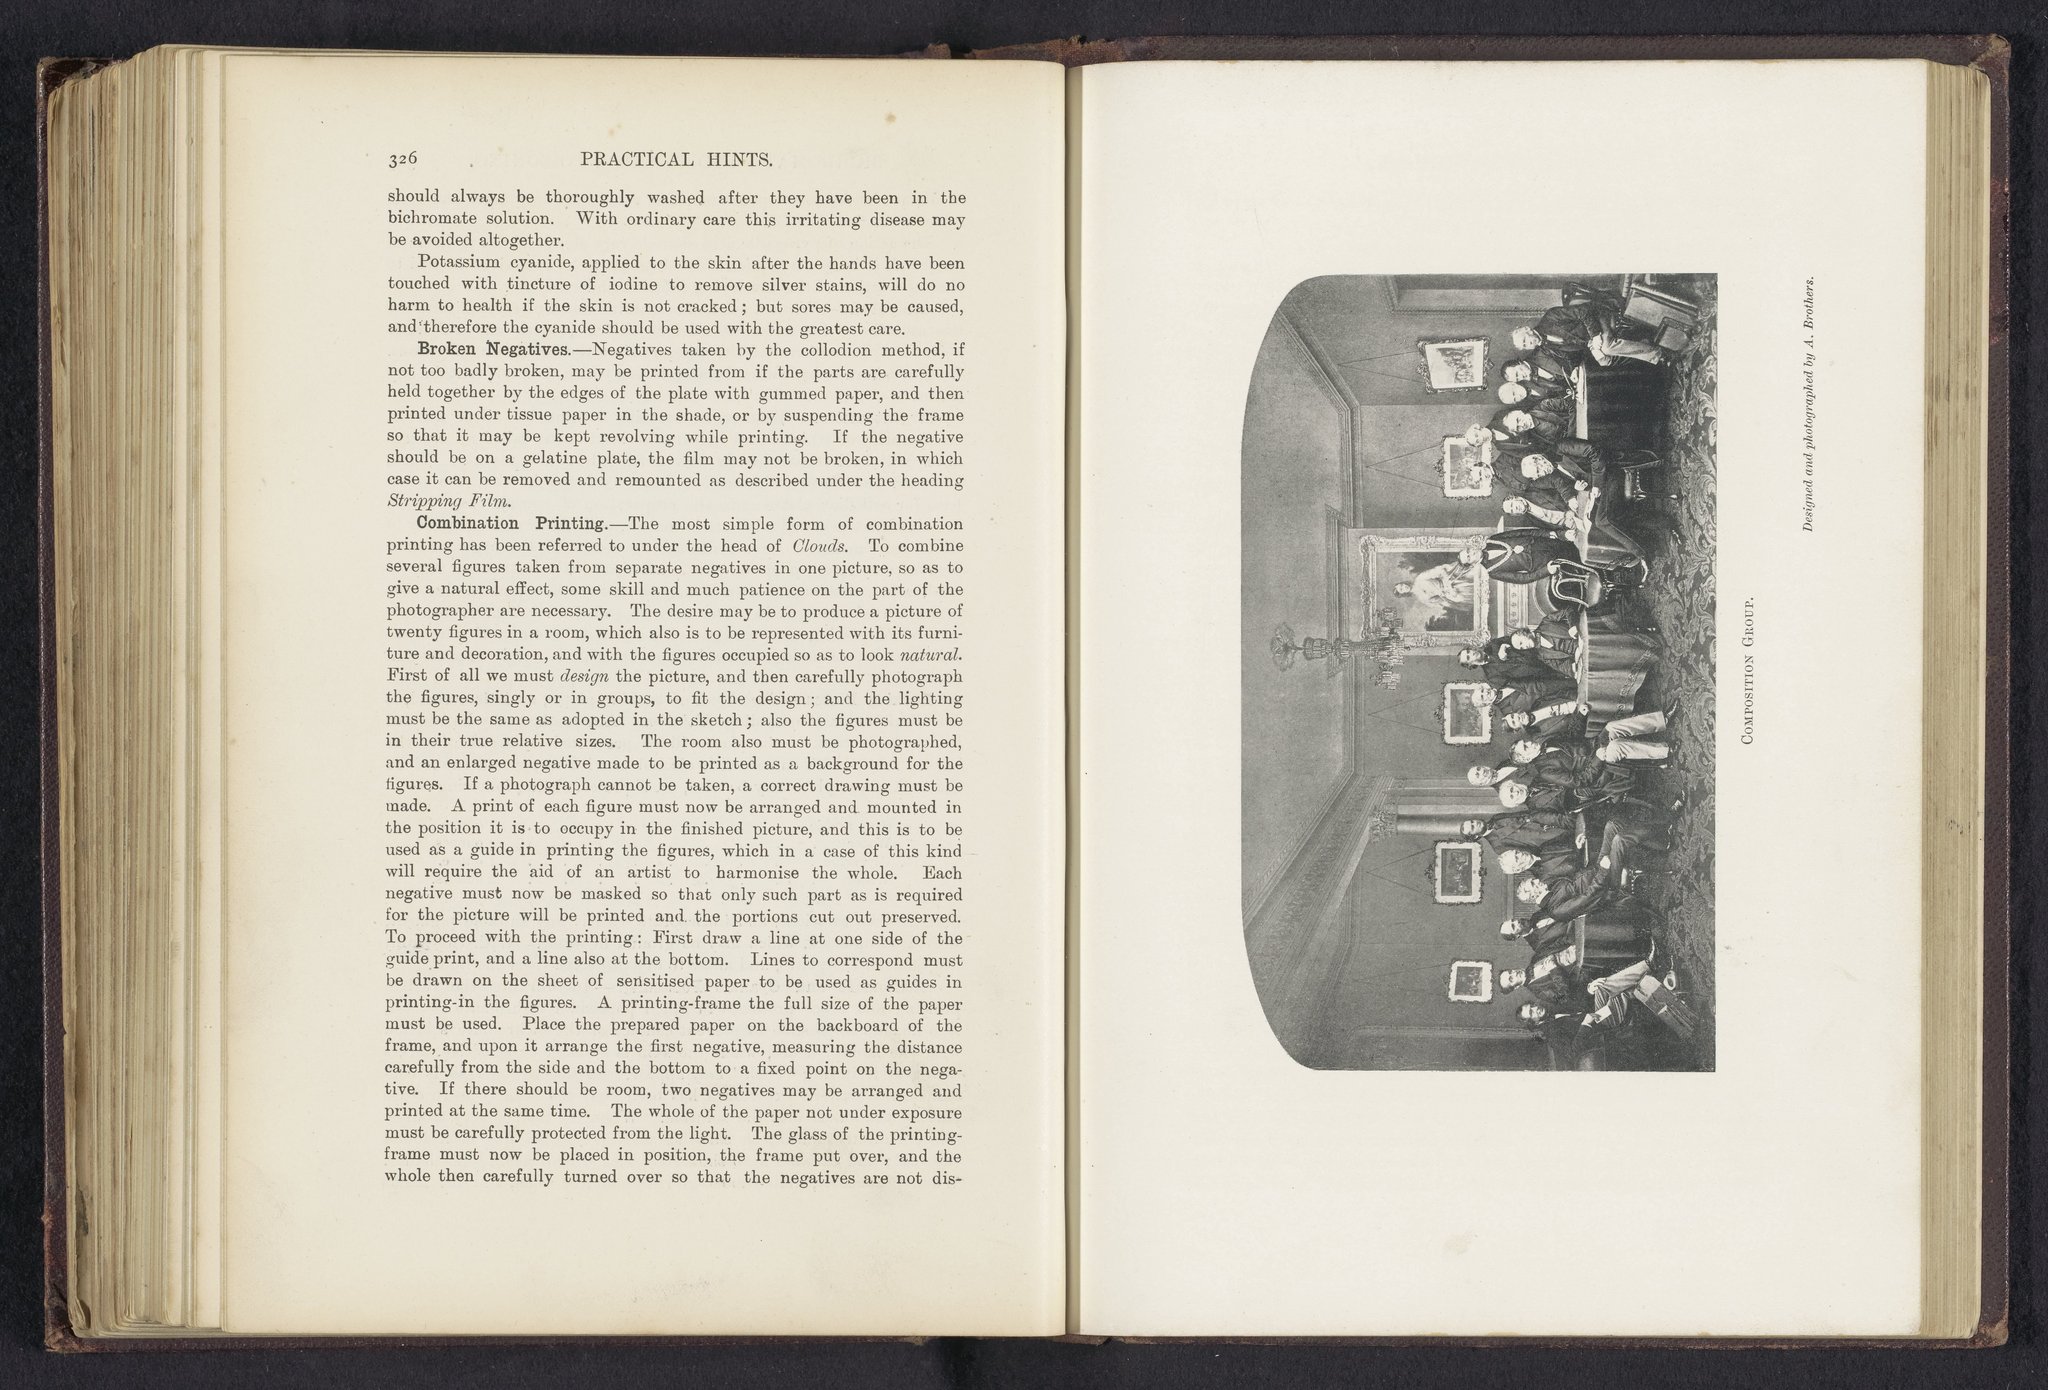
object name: page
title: Composition group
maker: Anonymous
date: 1889-1899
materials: paper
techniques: autotype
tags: exterior ~ representation of a building, anonymous historical persons portrayed in a group, in a group-portrait